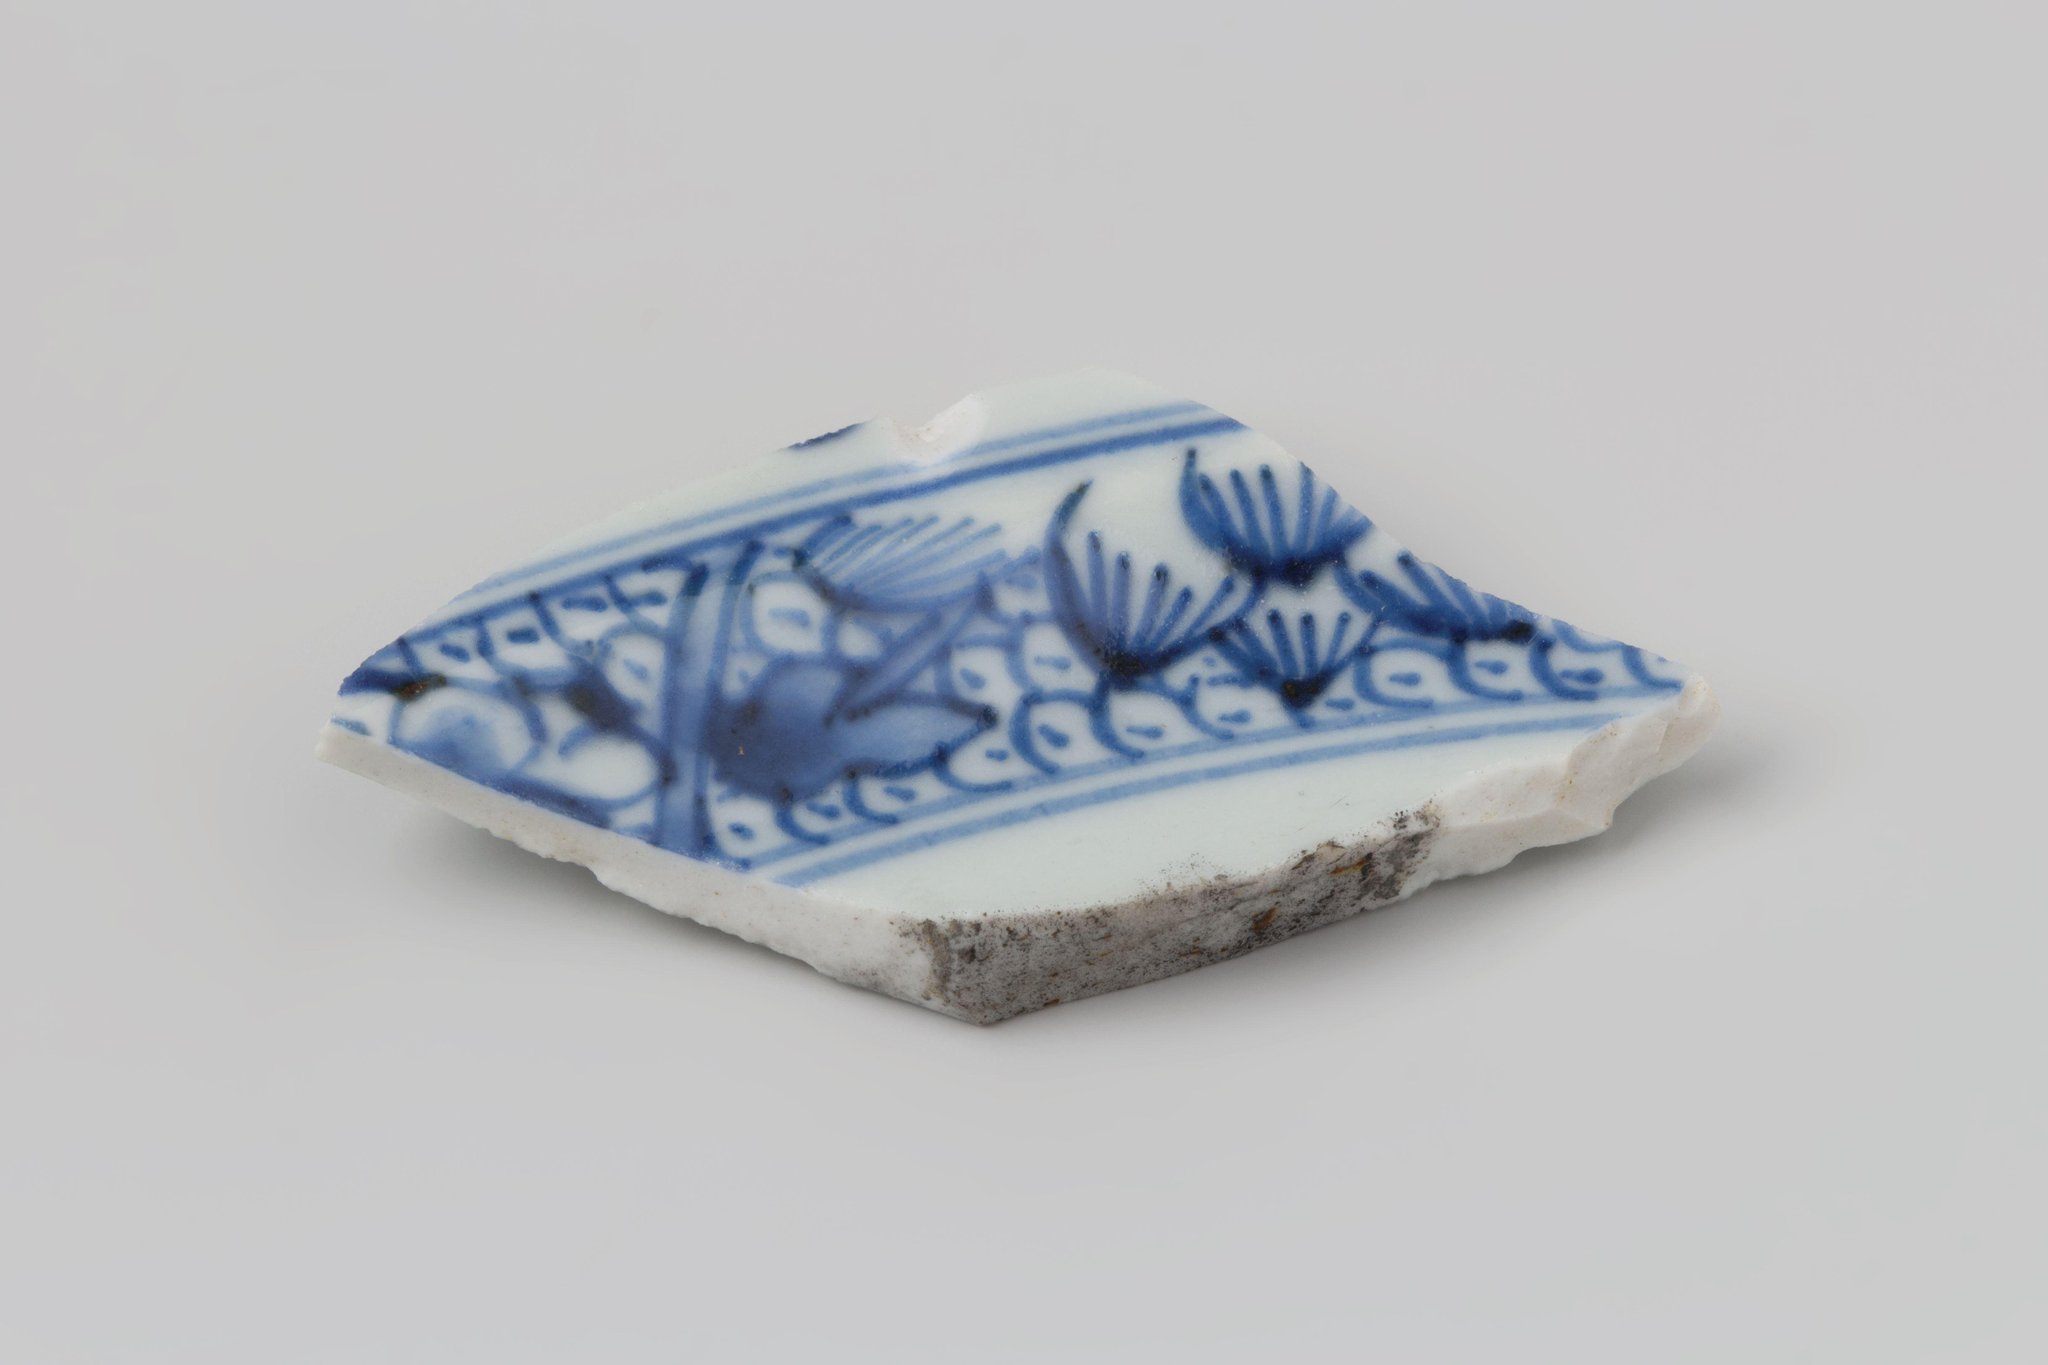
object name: plate dish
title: Scherf van een bord of schaal uit het wrak van de Oost-Indiëvaarder 't Vliegend Hart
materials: porcelain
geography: netherlands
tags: 't vliegend hart (schip), verenigde oostindische compagnie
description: Scherf van een delftsblauwe schaal. Porcelain.